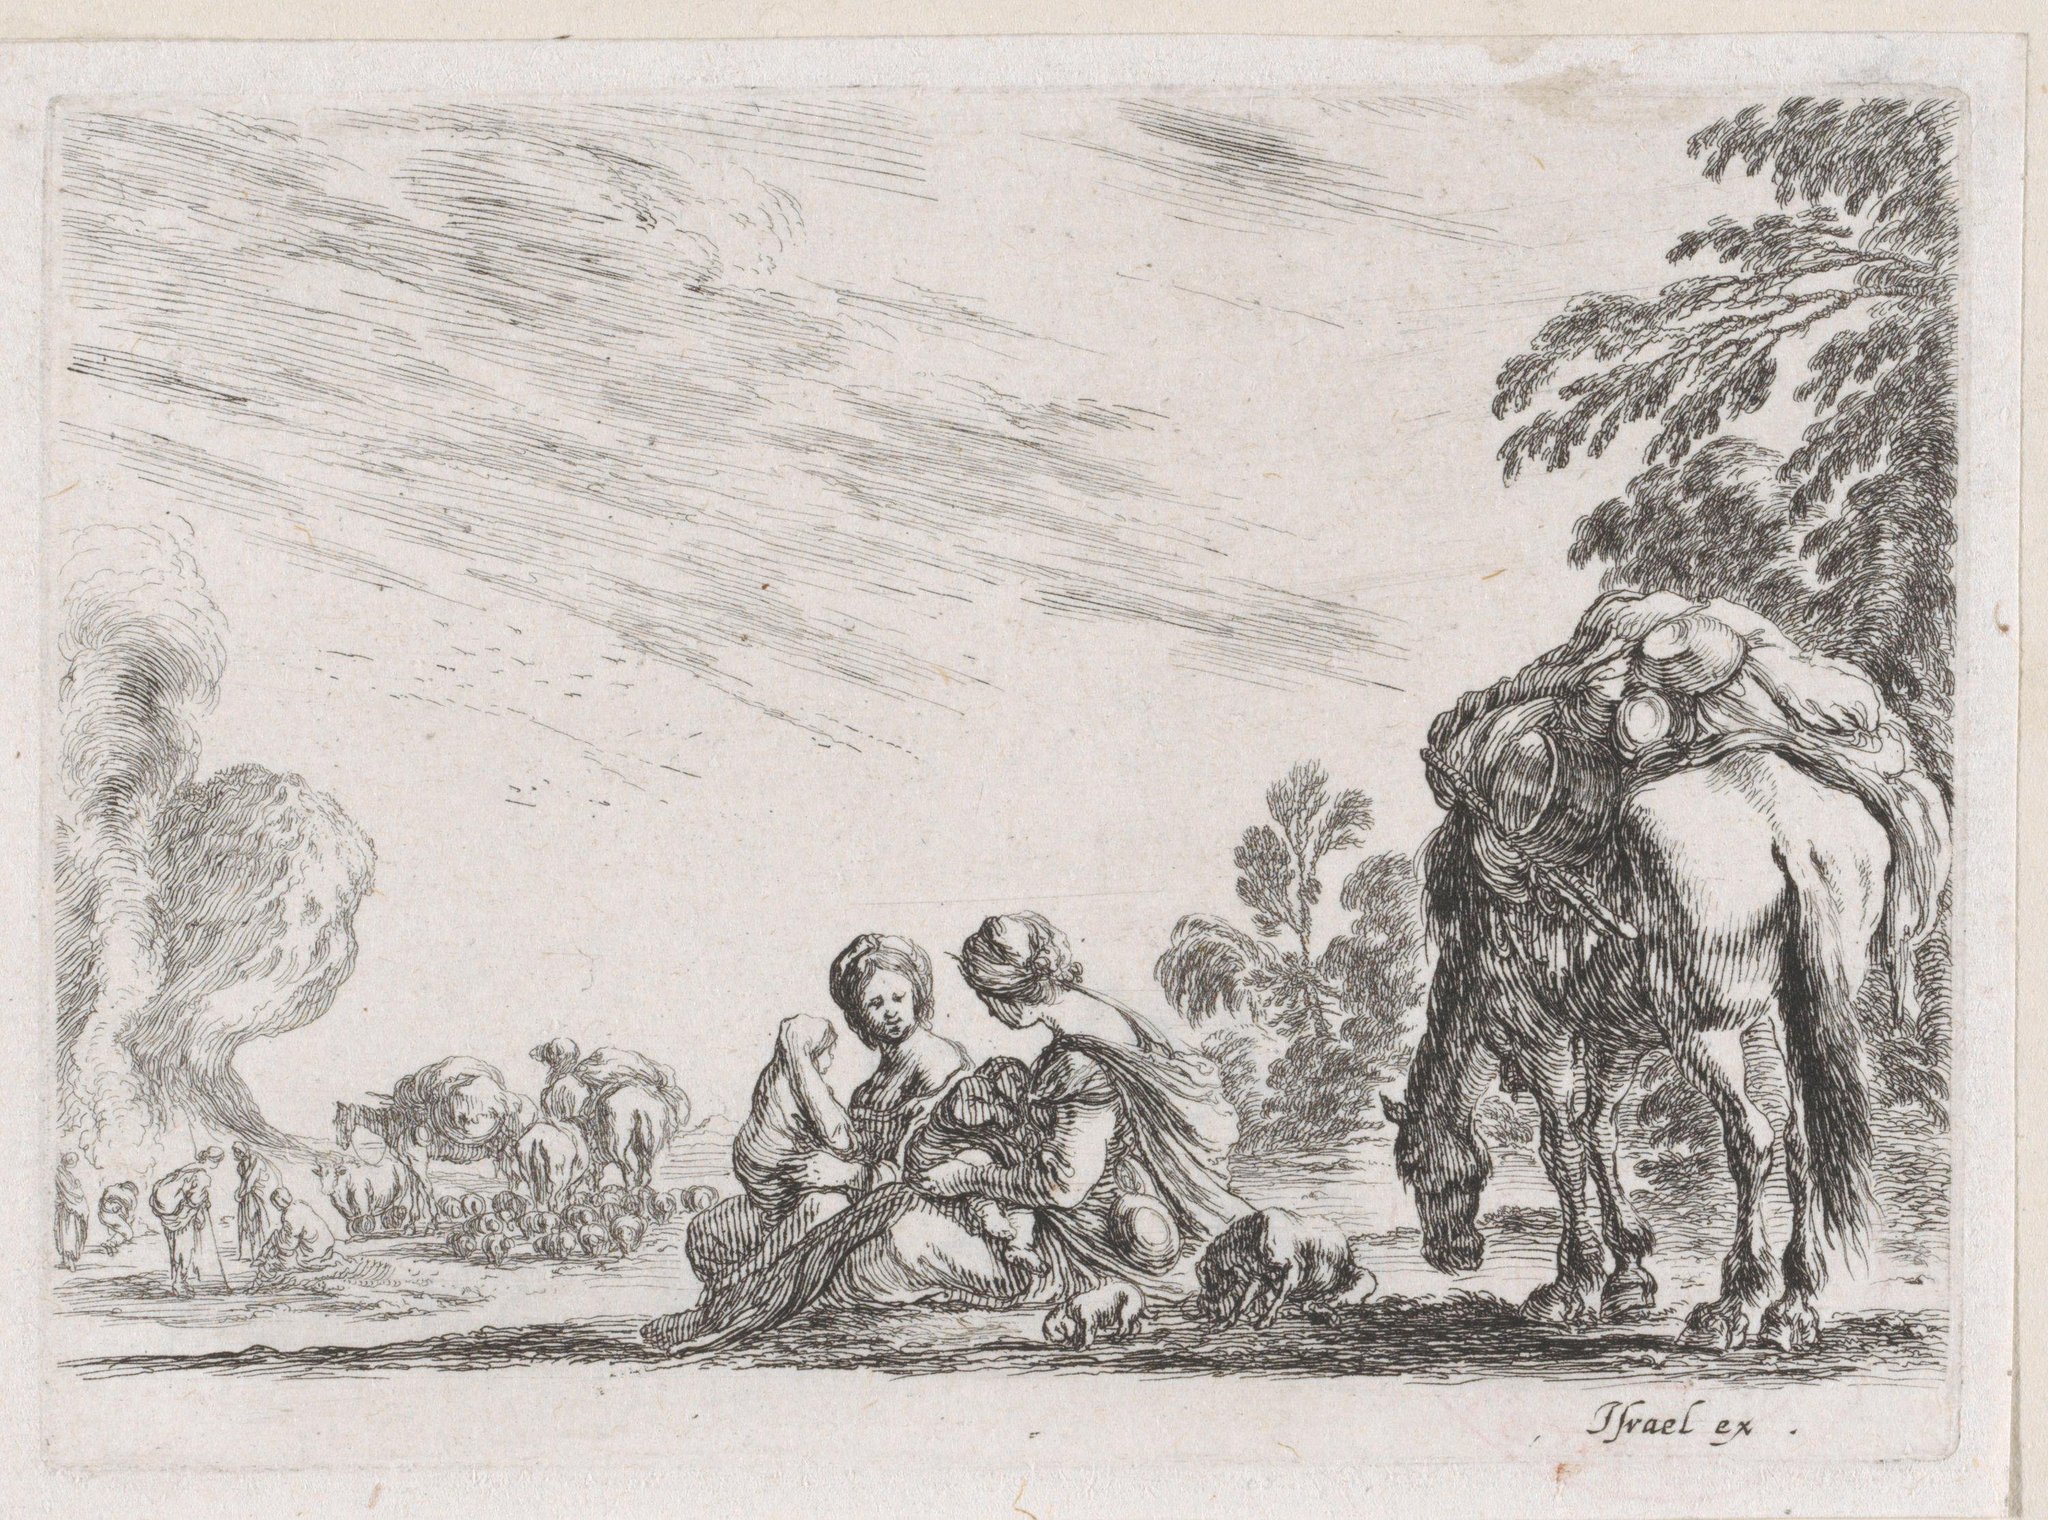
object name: print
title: Agreable diversité de figures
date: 1642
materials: paper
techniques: etching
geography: paris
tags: horse, wet-nurse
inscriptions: collector's mark: Lugt 240